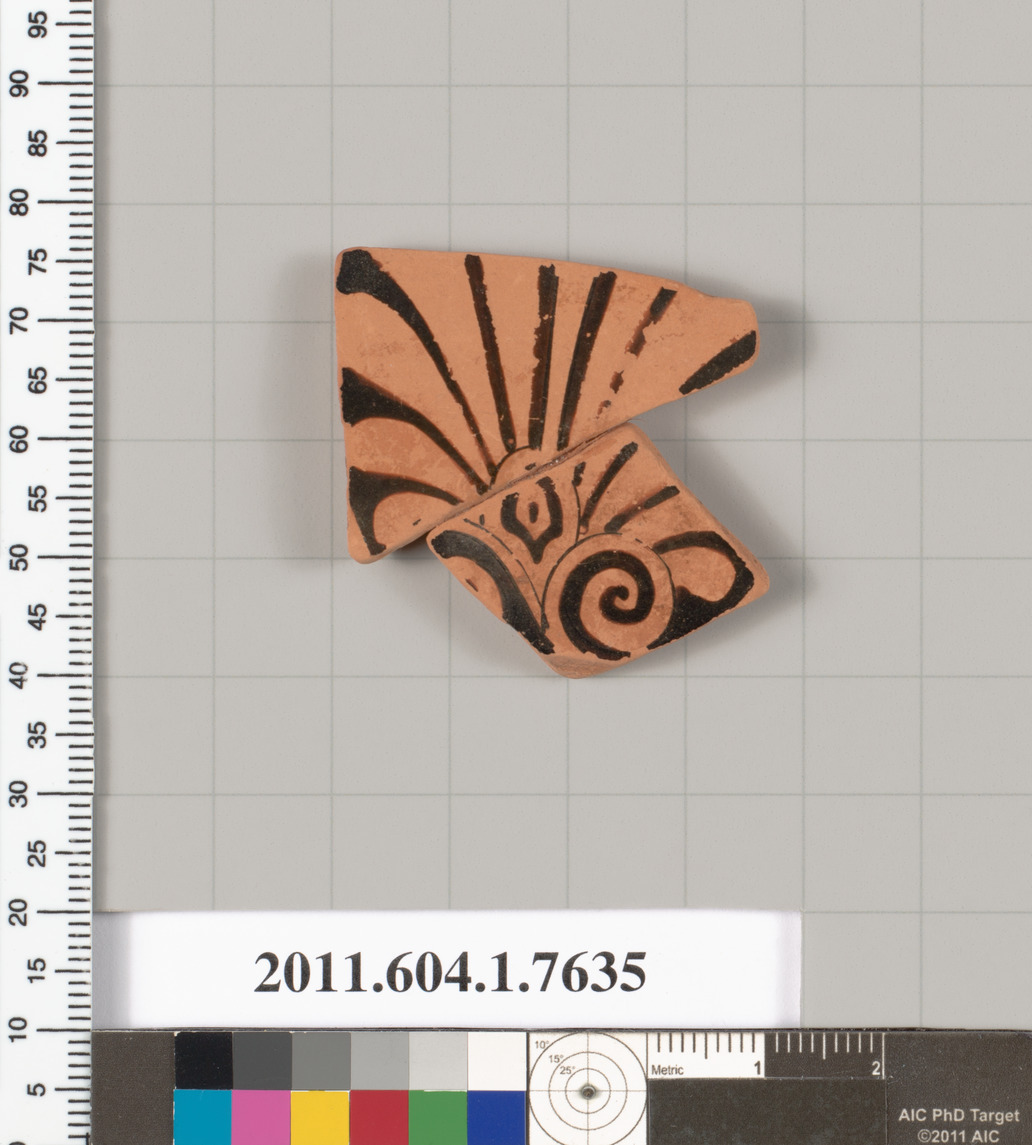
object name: kylix fragment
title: Terracotta fragment of a kylix (drinking cup)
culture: greek, attic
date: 460-450 BCE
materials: terracotta